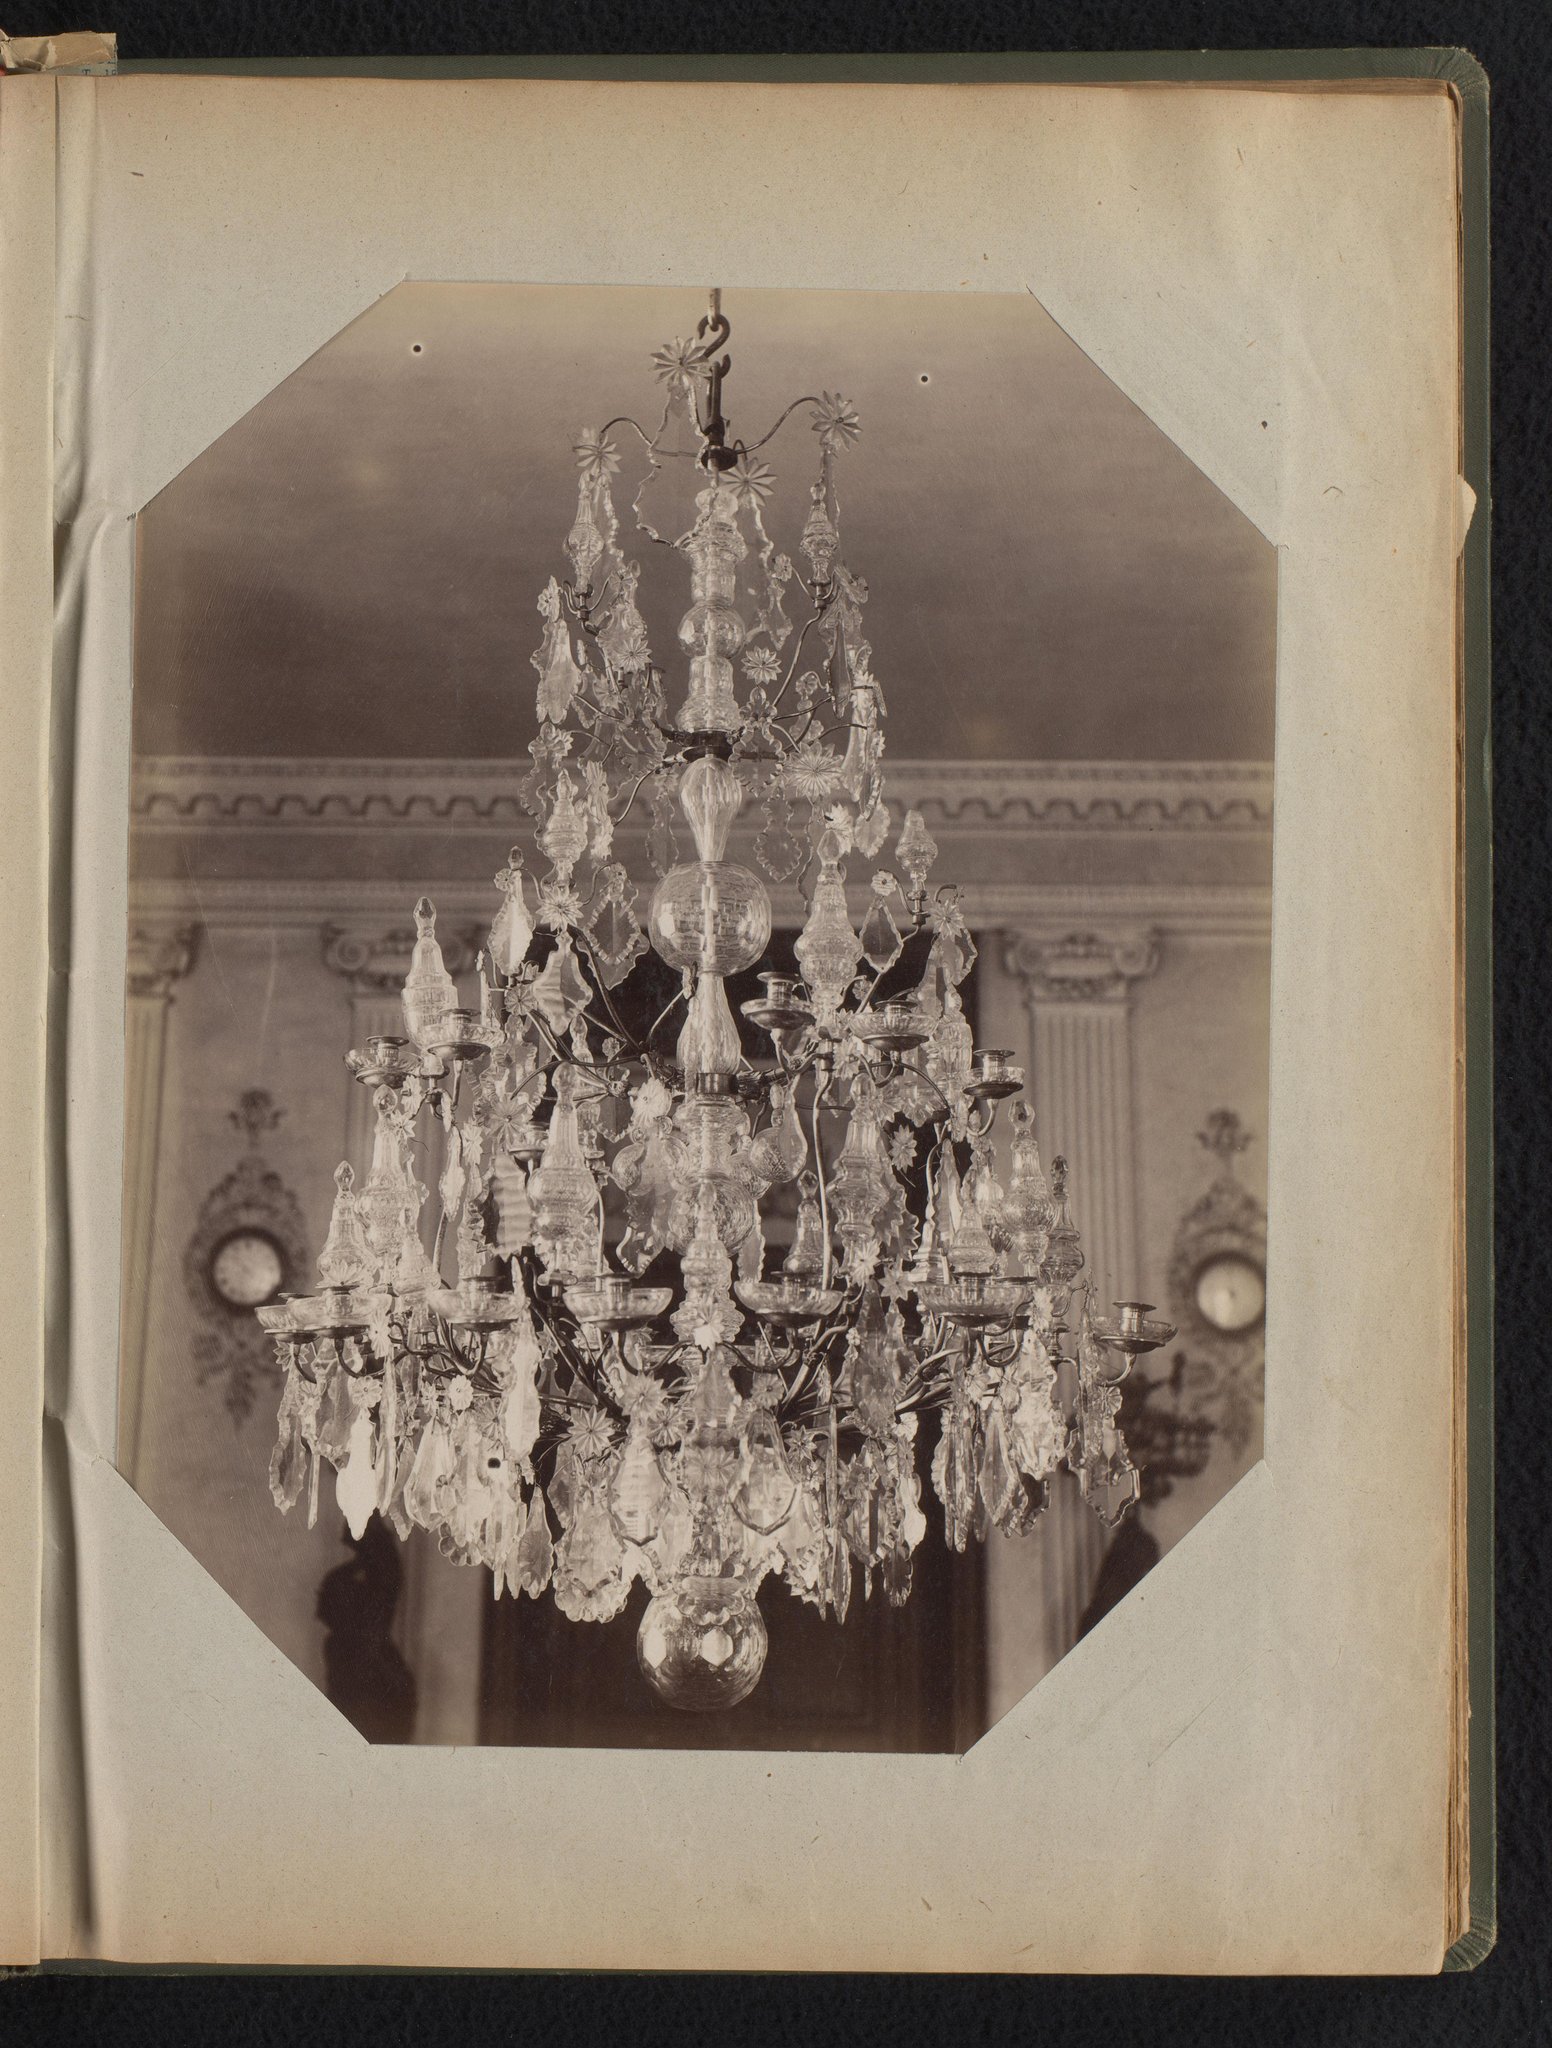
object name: photograph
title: Kroonluchter met kristallen ornamenten in paleis Versailles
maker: Anonymous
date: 1860-1900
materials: canvas, cardboard, paper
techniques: matte daylight collodion silver print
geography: netherlands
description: Onderdeel van een serie met betrekking tot het interieur van het paleis van Versailles met kroonluchters, deuren, portalen en meubelstukken.